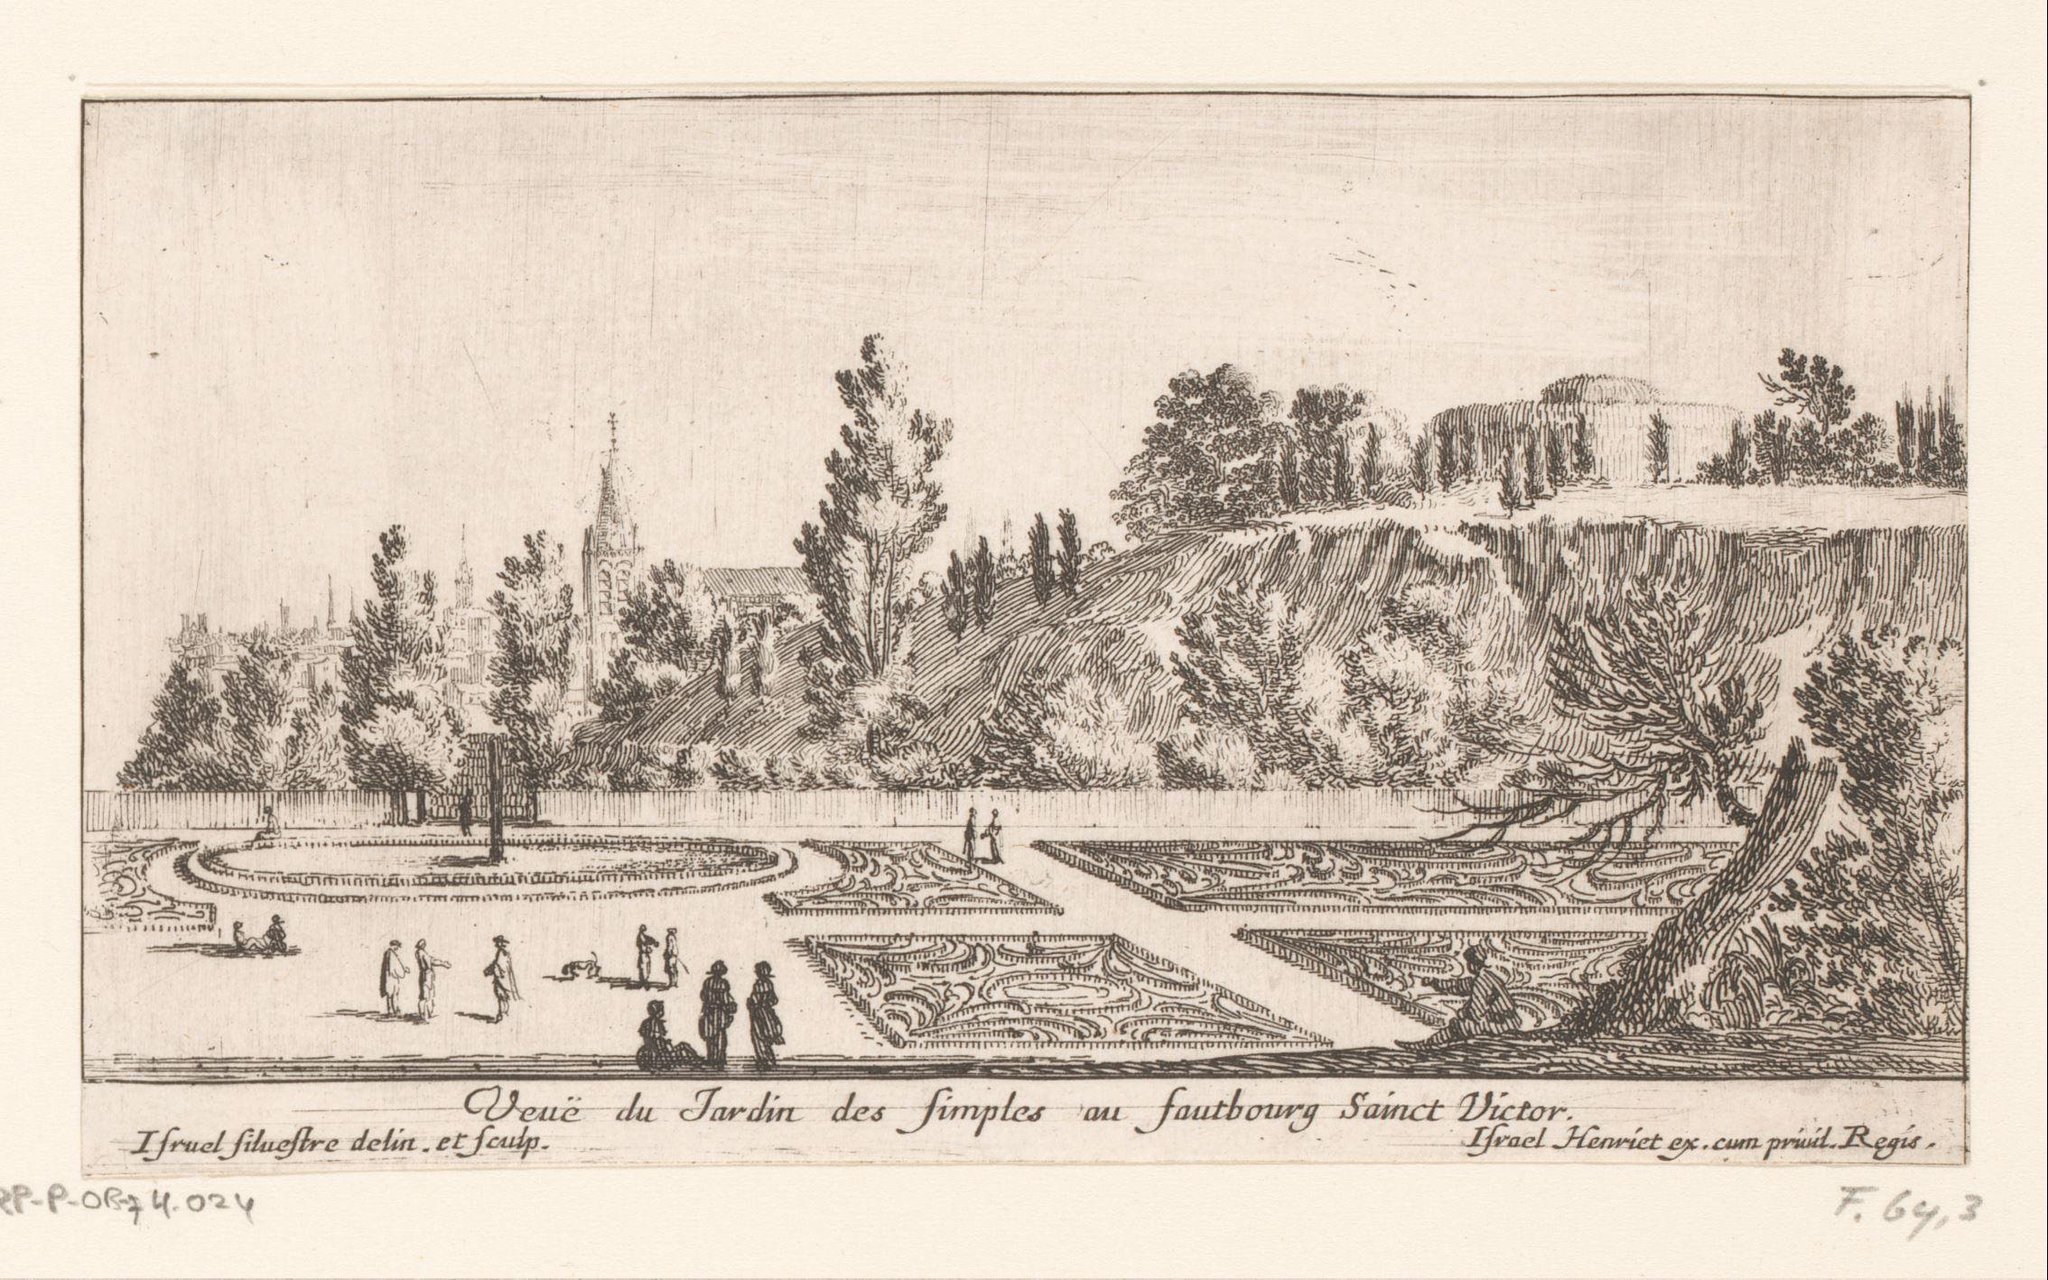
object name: print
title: Diverse landschappen gemaakt door Israël Silvestre in 1652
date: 1652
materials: paper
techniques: engraving, etching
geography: france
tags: city-view, and landscape with man-made constructions, french or architectonic garden; formal garden, paris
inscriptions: collector's mark: Lugt 240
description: Prent maakt deel uit van een ongenummerde serie van 30 prenten.